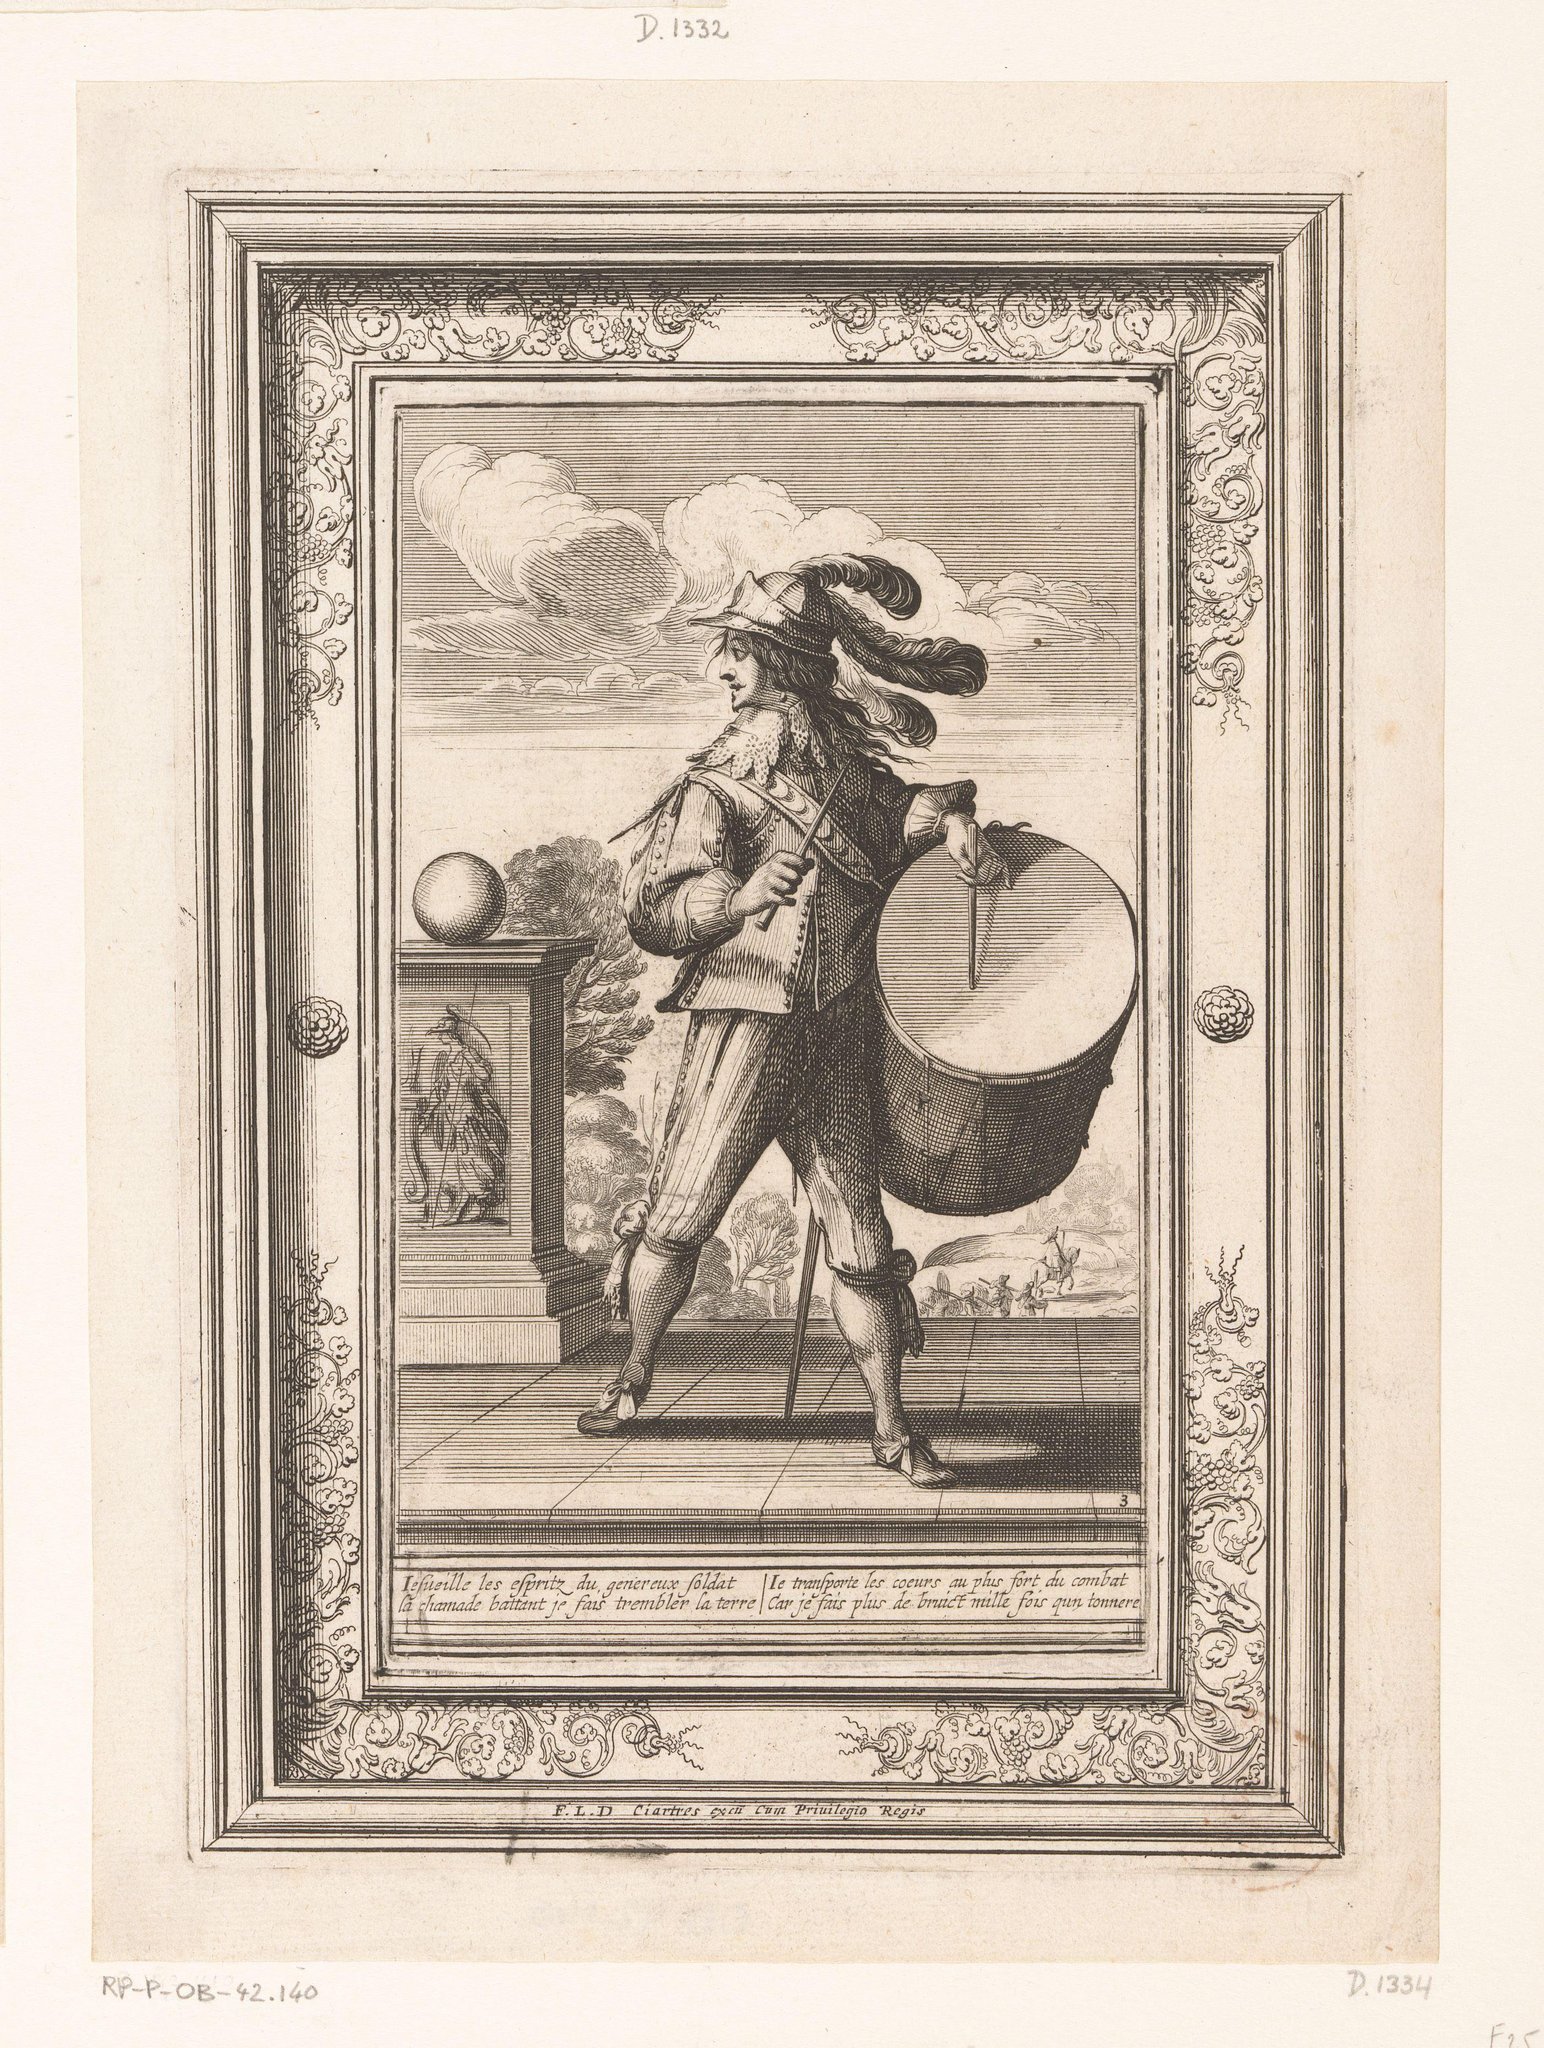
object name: costume print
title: Drummer of the French Royal Guard, c. 1630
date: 1639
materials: paper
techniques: engraving, etching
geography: paris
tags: military music, drum-head court-martial, drum (musical instrument), clothes, costume (+ men's clothes), the soldier; the soldier's life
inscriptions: collector's mark: Lugt 240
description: Maakt deel uit van een serie met acht kostuumprenten en een titelprent van de Franse koninklijke garde, in de voor hen passende kleding. De serie werd in 1632 uitgegeven in Parijs door Melchior Tavernier. Een tweede staat werd uitgegeven door François Langlois in 1639.